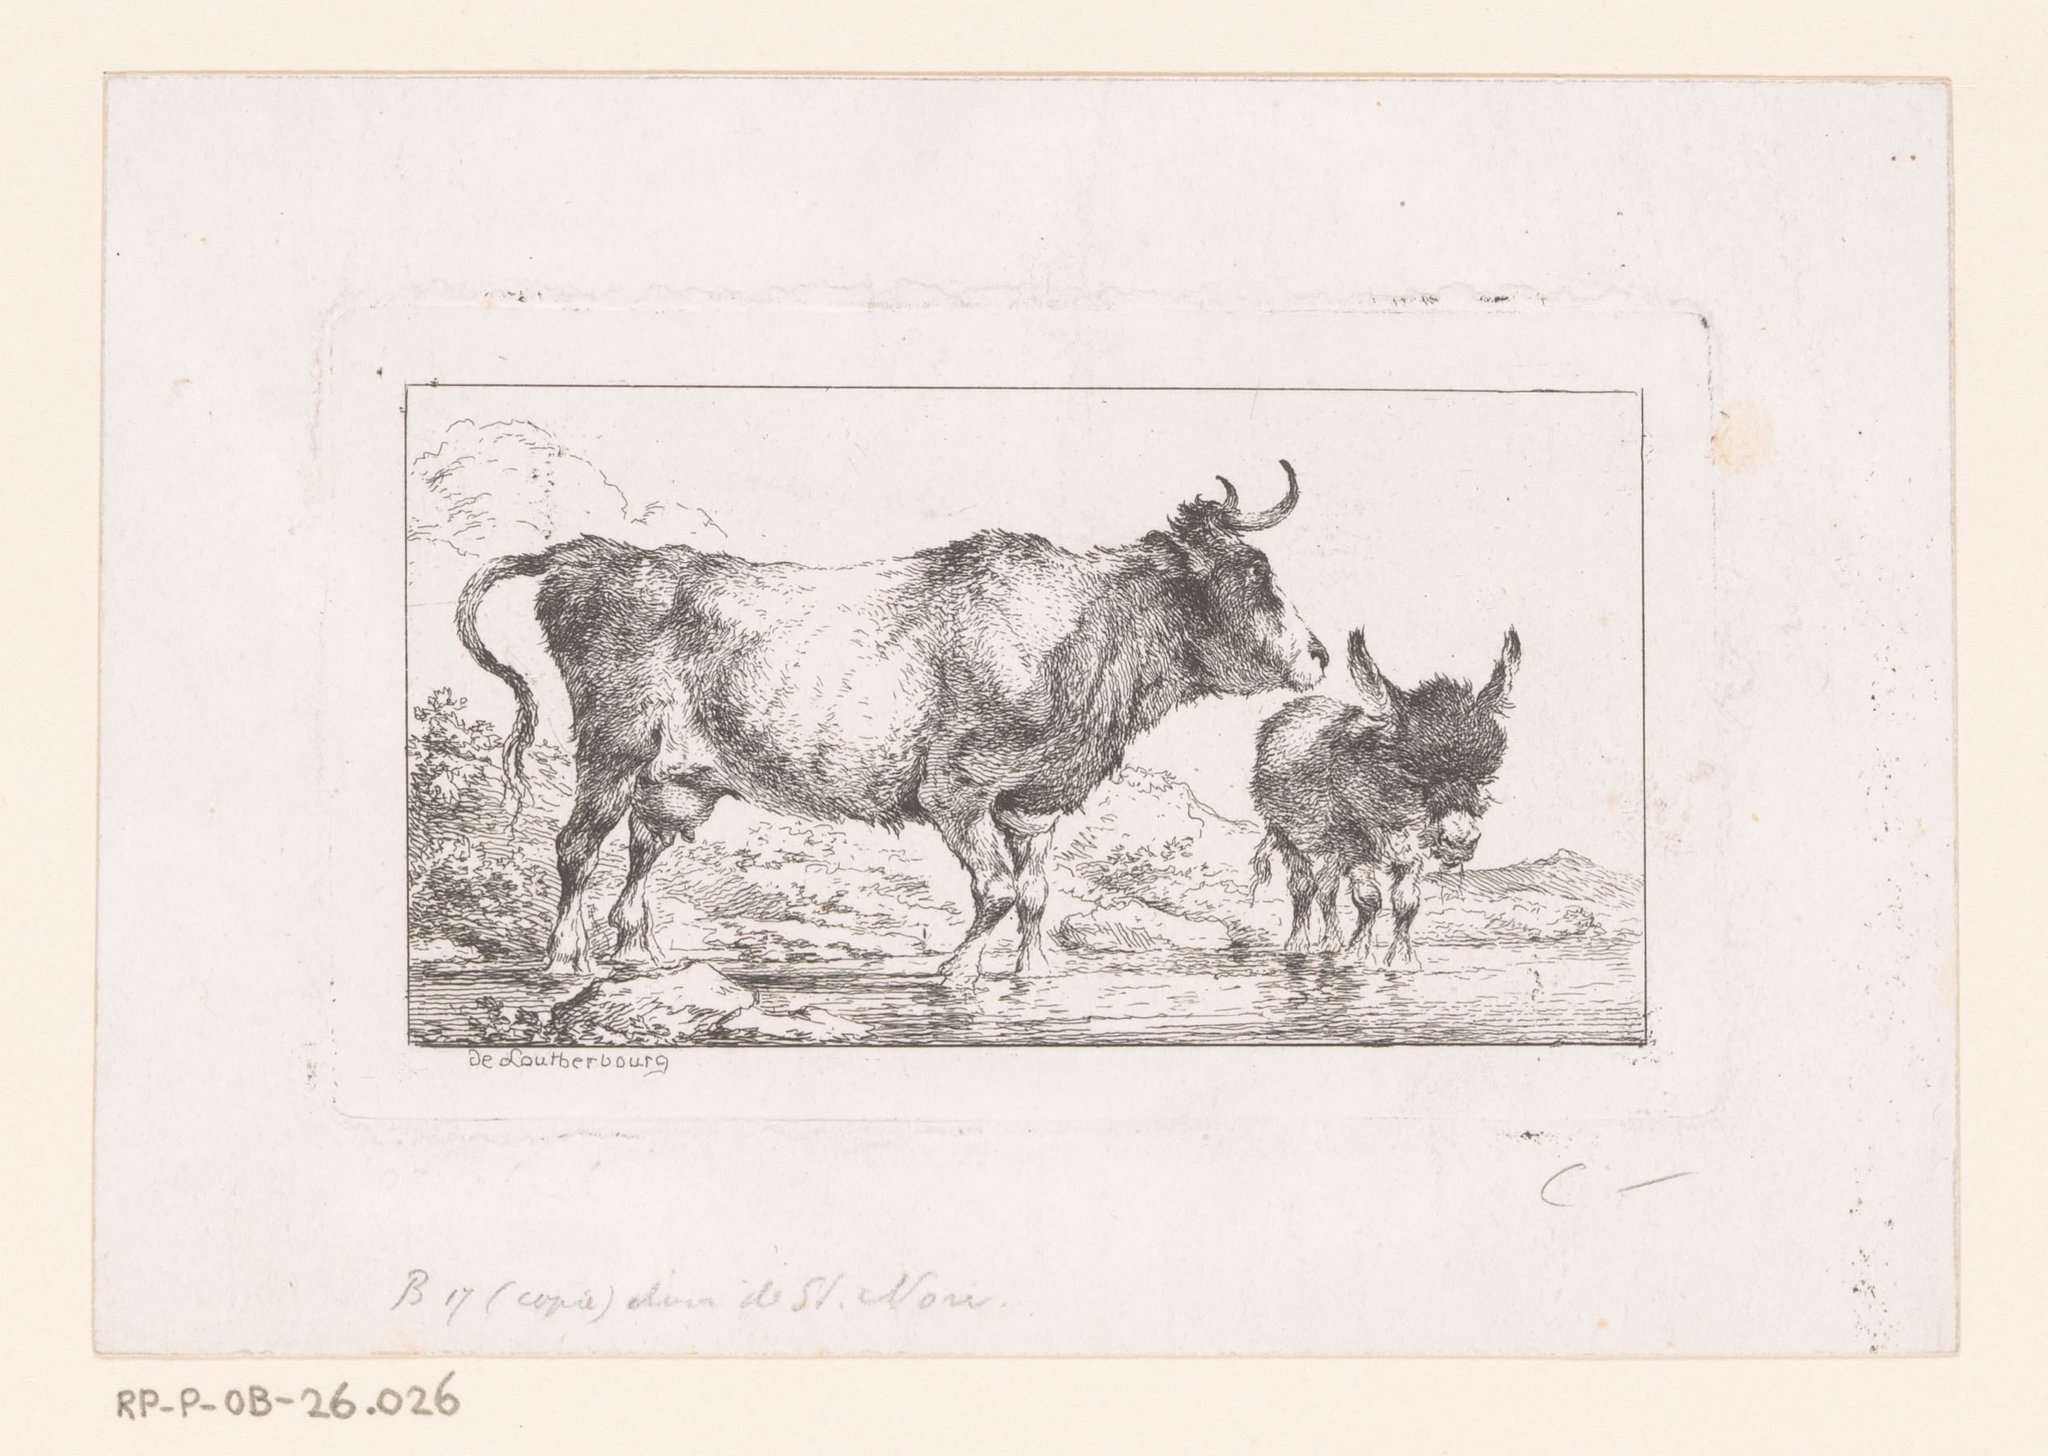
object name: print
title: Koe en ezel staand in een rivier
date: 1755-1791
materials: paper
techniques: etching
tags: cow, ass, donkey, landscapes with waters, waterscapes, seascapes (in the temperate zone)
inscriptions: collector's mark: Lugt 2228